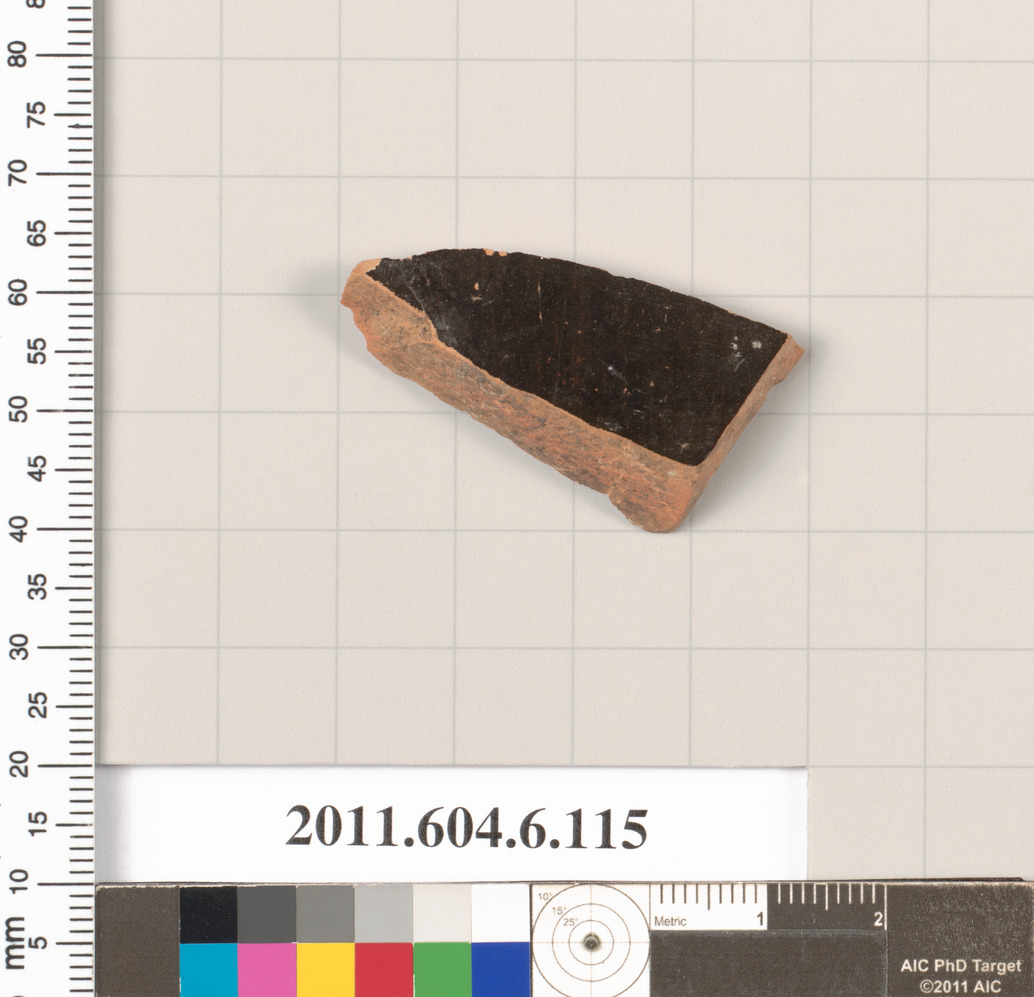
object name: undetermined closed shape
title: Terracotta fragment of a closed shape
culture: greek, attic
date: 600-401 BCE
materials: terracotta